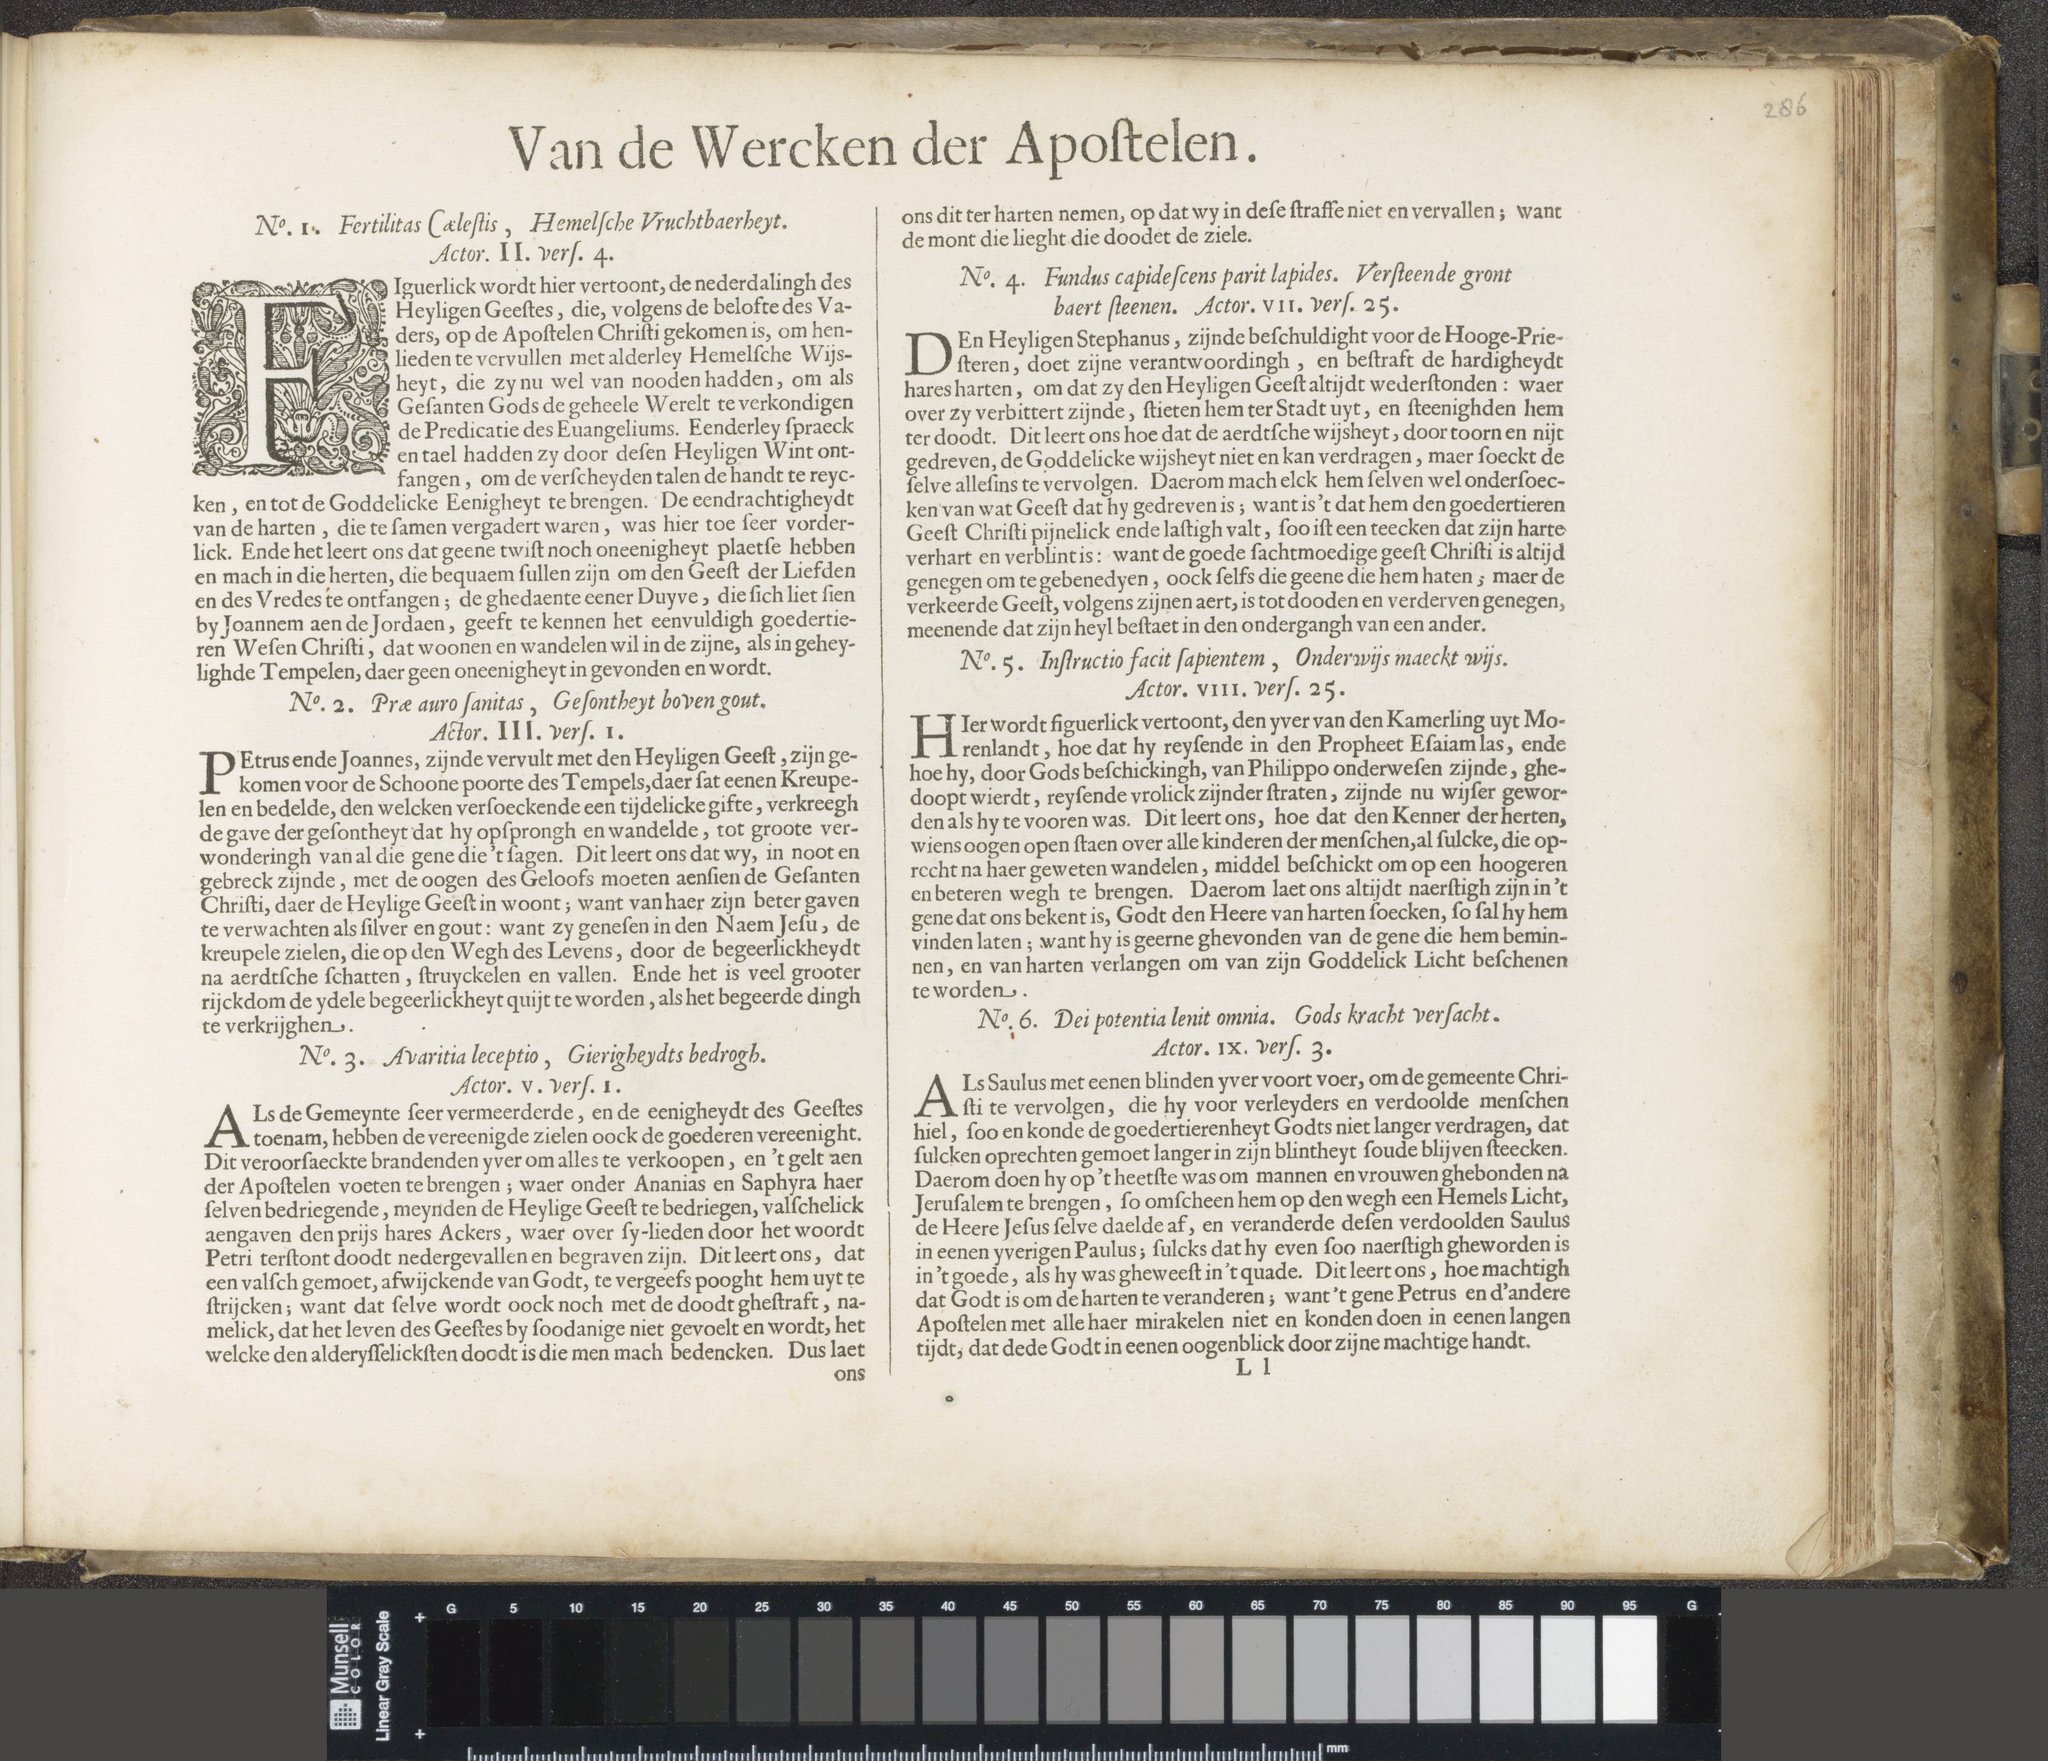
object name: text sheet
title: Den Grooten Emblemata Sacra, bestaande in meer dan vier hondert bybelsche figuren, zoo des Ouden als des Nieuwen Testaments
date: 1653-1654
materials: paper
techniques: letterpress printing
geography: amsterdam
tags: initial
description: Zes toelichtingen bij voorstellingen over de werken van de apostelen, genummerd een tot en met zes. De tekst vangt aan met een gedecoreerde initiaal F. Het blad maakt deel uit van een album.